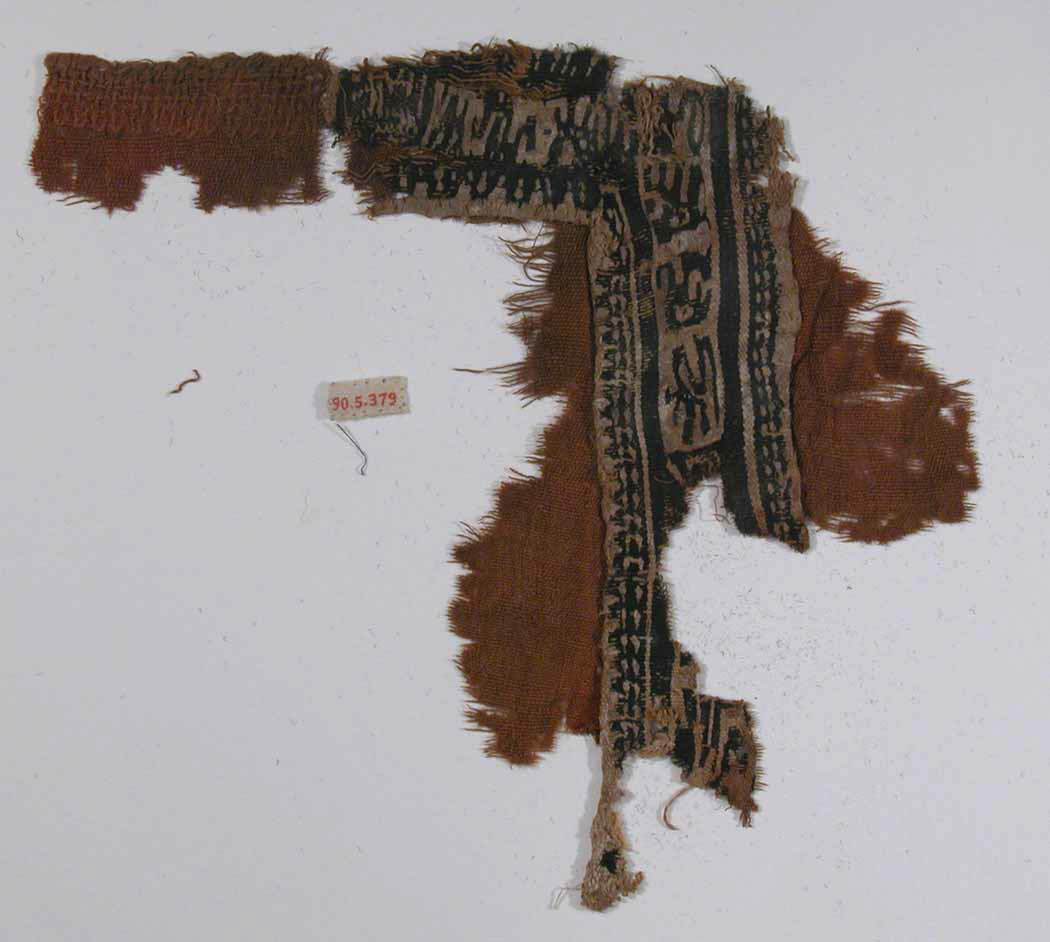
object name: textile fragment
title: Fragment of a Tunic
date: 301-500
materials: linen, wool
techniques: weave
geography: egypt